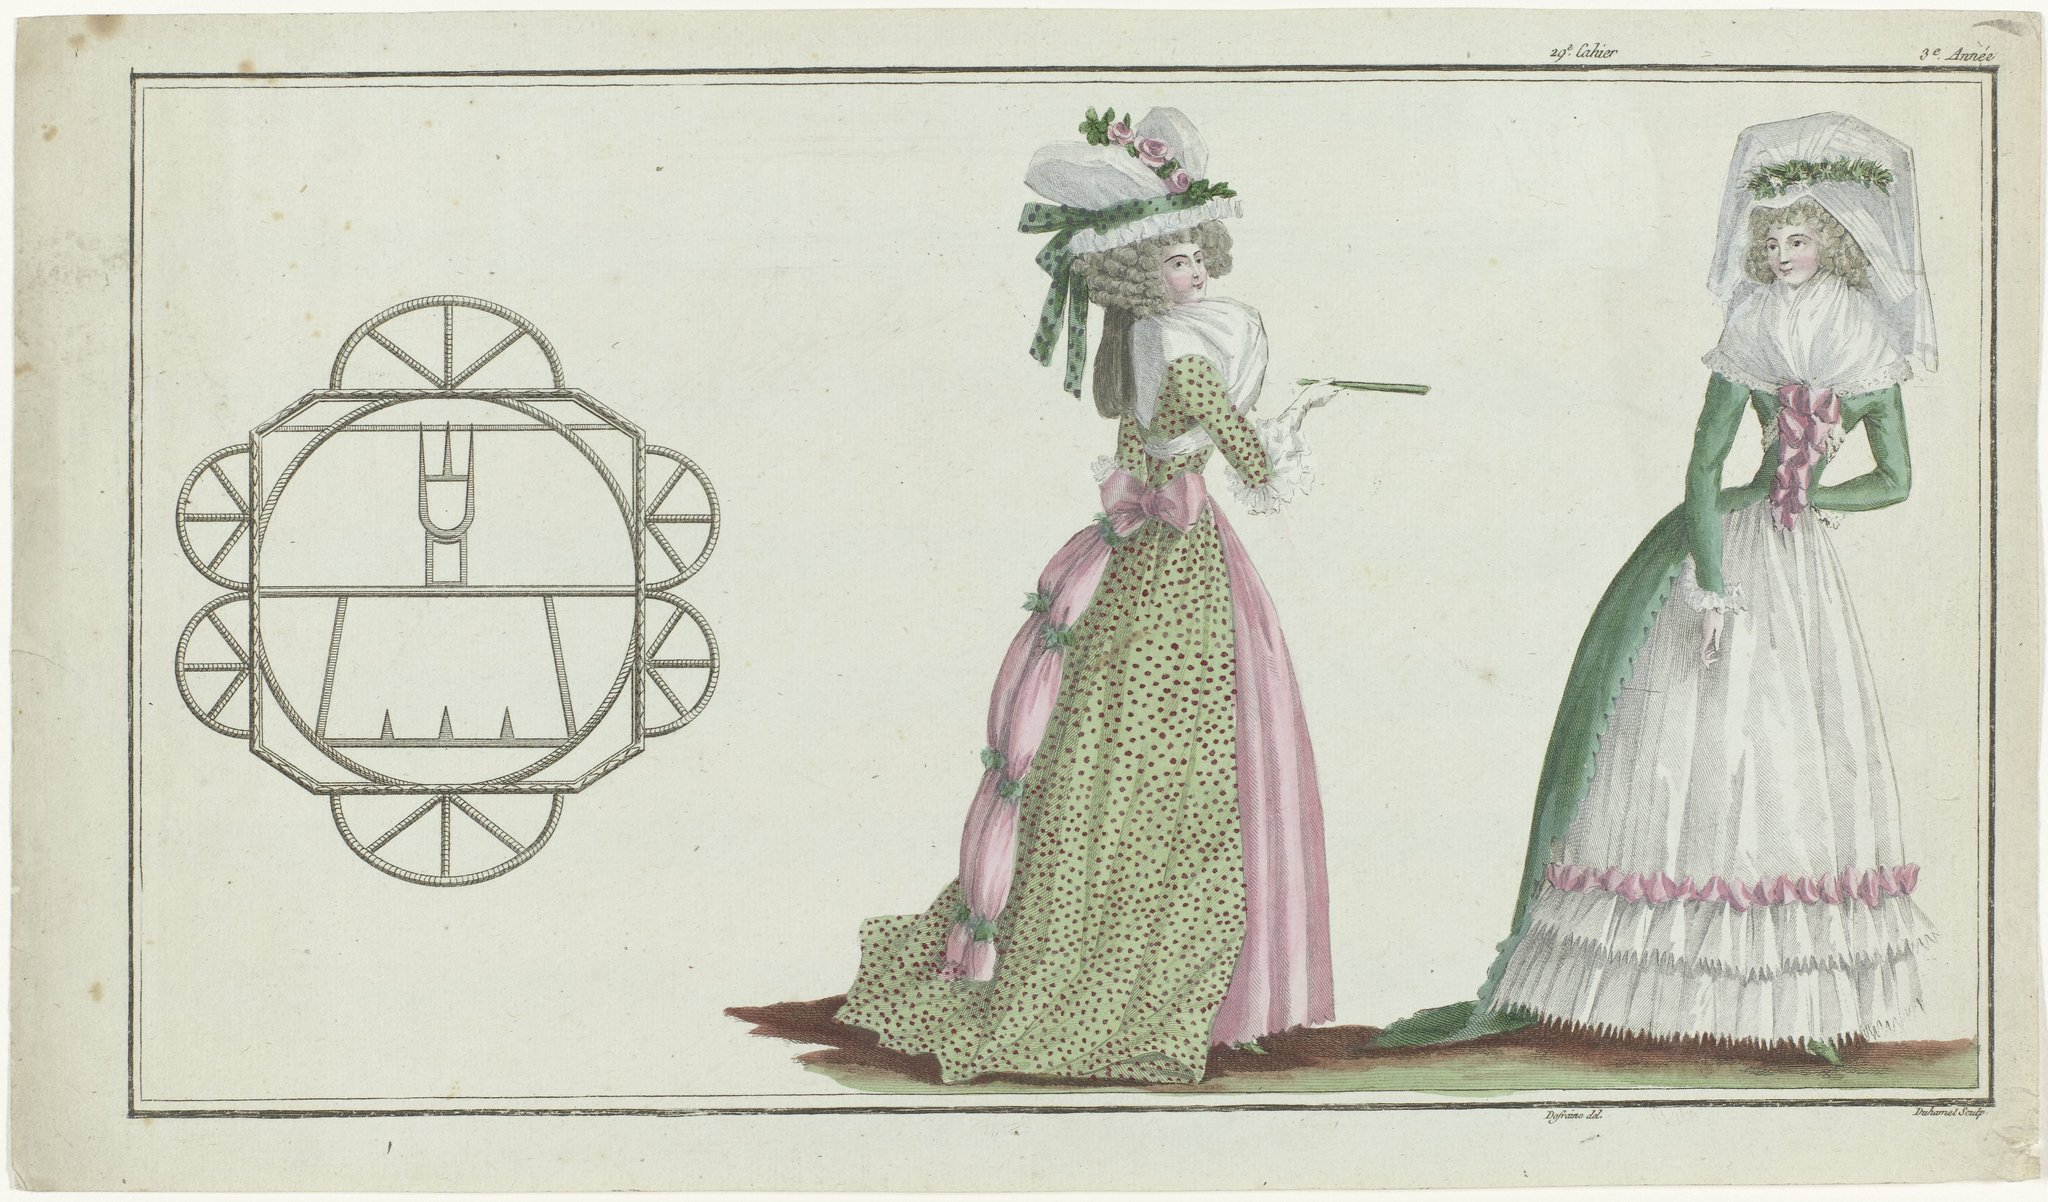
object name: fashion print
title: The First Fashion Magazine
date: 1788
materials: paper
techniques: engraving, hand coloring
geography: paris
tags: buckle, dress, gown: redingote (+ women's clothes), head-gear: cap (+ women's clothes), fashion plates, skirt (+ women's clothes), fan (+ women's clothes), piece of clothing covering the breast or décolleté (fichu) (+ women's clothes)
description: The Cabinet des Modes ou les Modes Nouvelles first appeared on 15 November 1785. As the first real fashion magazine, it was published on a regular basis and wholly dedicated to news from the world of fashion. It was available by subscription only and distributed both in France and abroad. Each eight-page edition contained three hand-coloured engravings. After a year in print, the magazine changed its name to Magasin des Modes Nouvelles Françaises et Anglaises. Instead of three loose sheets, it now included a single fold-out plate depicting clothes and accessories. Publication of the Magasin ceased abruptly in 1789; after this, it was most likely succeeded by the Journal de la Mode et du Goût.